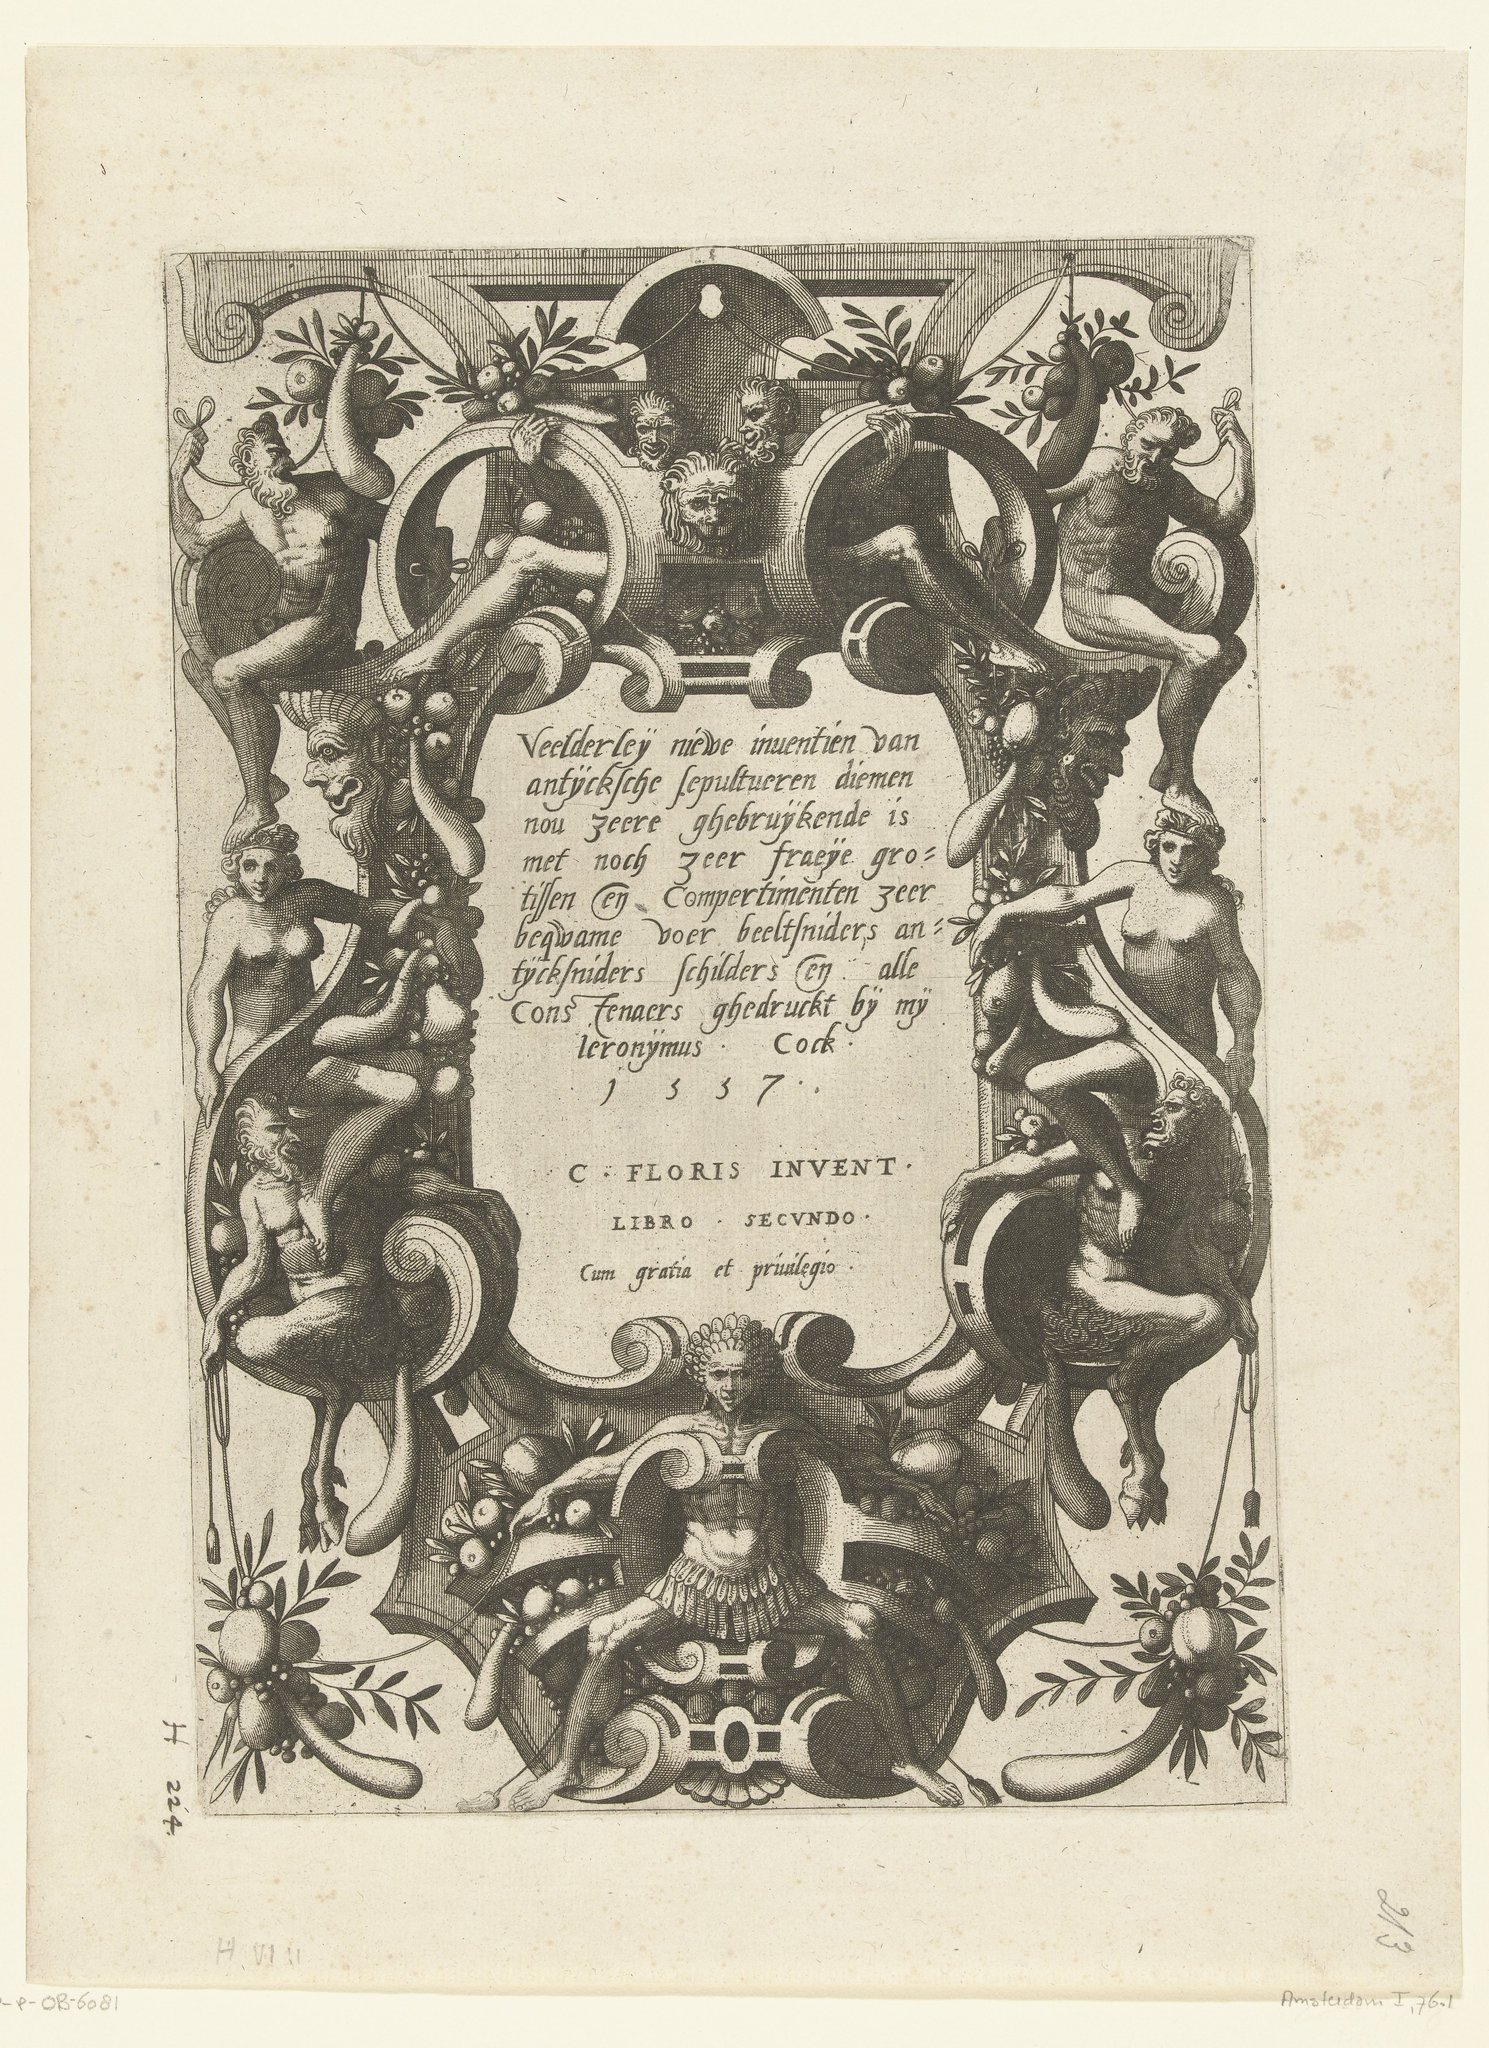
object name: print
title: Veelderleij niewe inuentien (...)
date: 1557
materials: paper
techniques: etching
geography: netherlands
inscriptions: date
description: Cartouche in een omlijsting van rolwerk waarin zeven saters en twee vrouwen zitten. Hoort bij serie bestaande uit een titelblad, een tekstblad en 14 bladen met grotesken met rolwerk, saters, guirlandes, trofeeën, dieren en fantasiewezens.